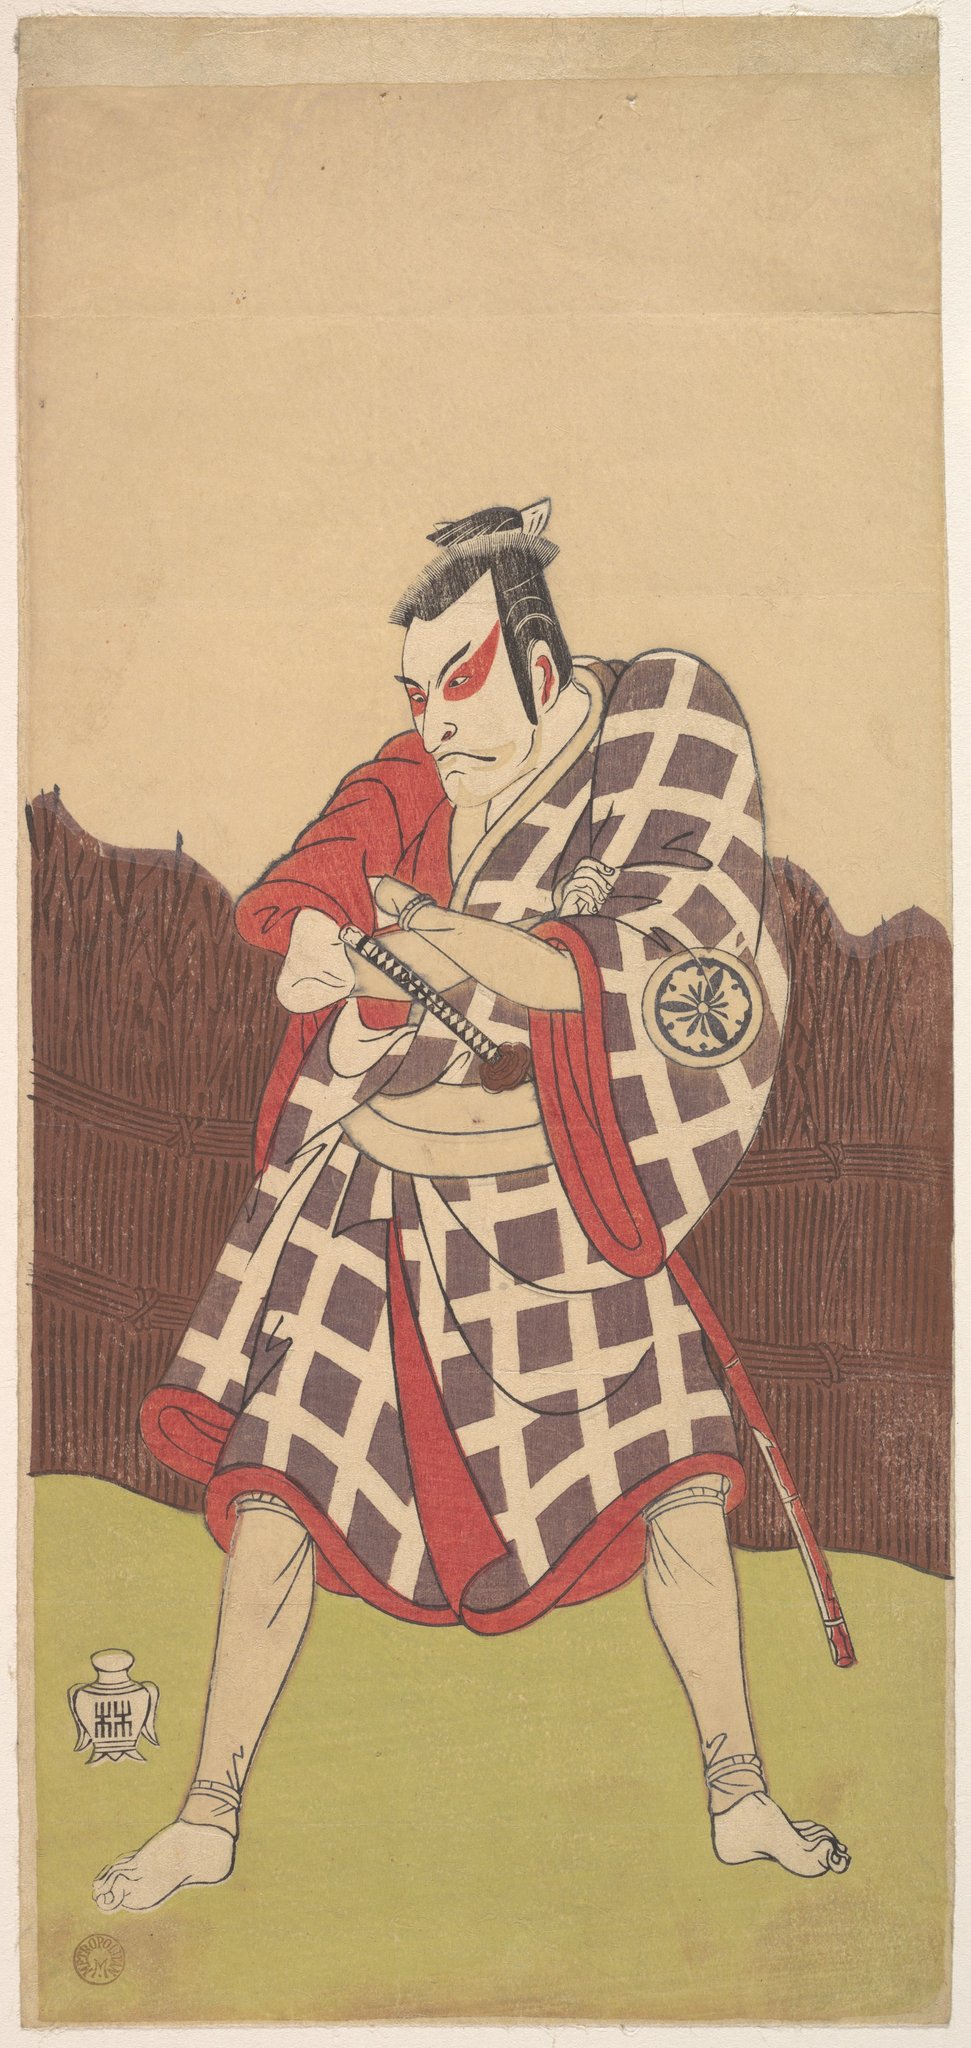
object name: woodblock print nishiki e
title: The Actor Matsumoto Koshiro 3rd as a Man who Stands with Arms Folded near a Brush Fence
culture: japanese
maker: katsukawa shunshō 勝川春章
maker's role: artist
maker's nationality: japanese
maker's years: 1726-1792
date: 1726-1792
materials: ink, paper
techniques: nishiki e, woodblock print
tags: men,actors